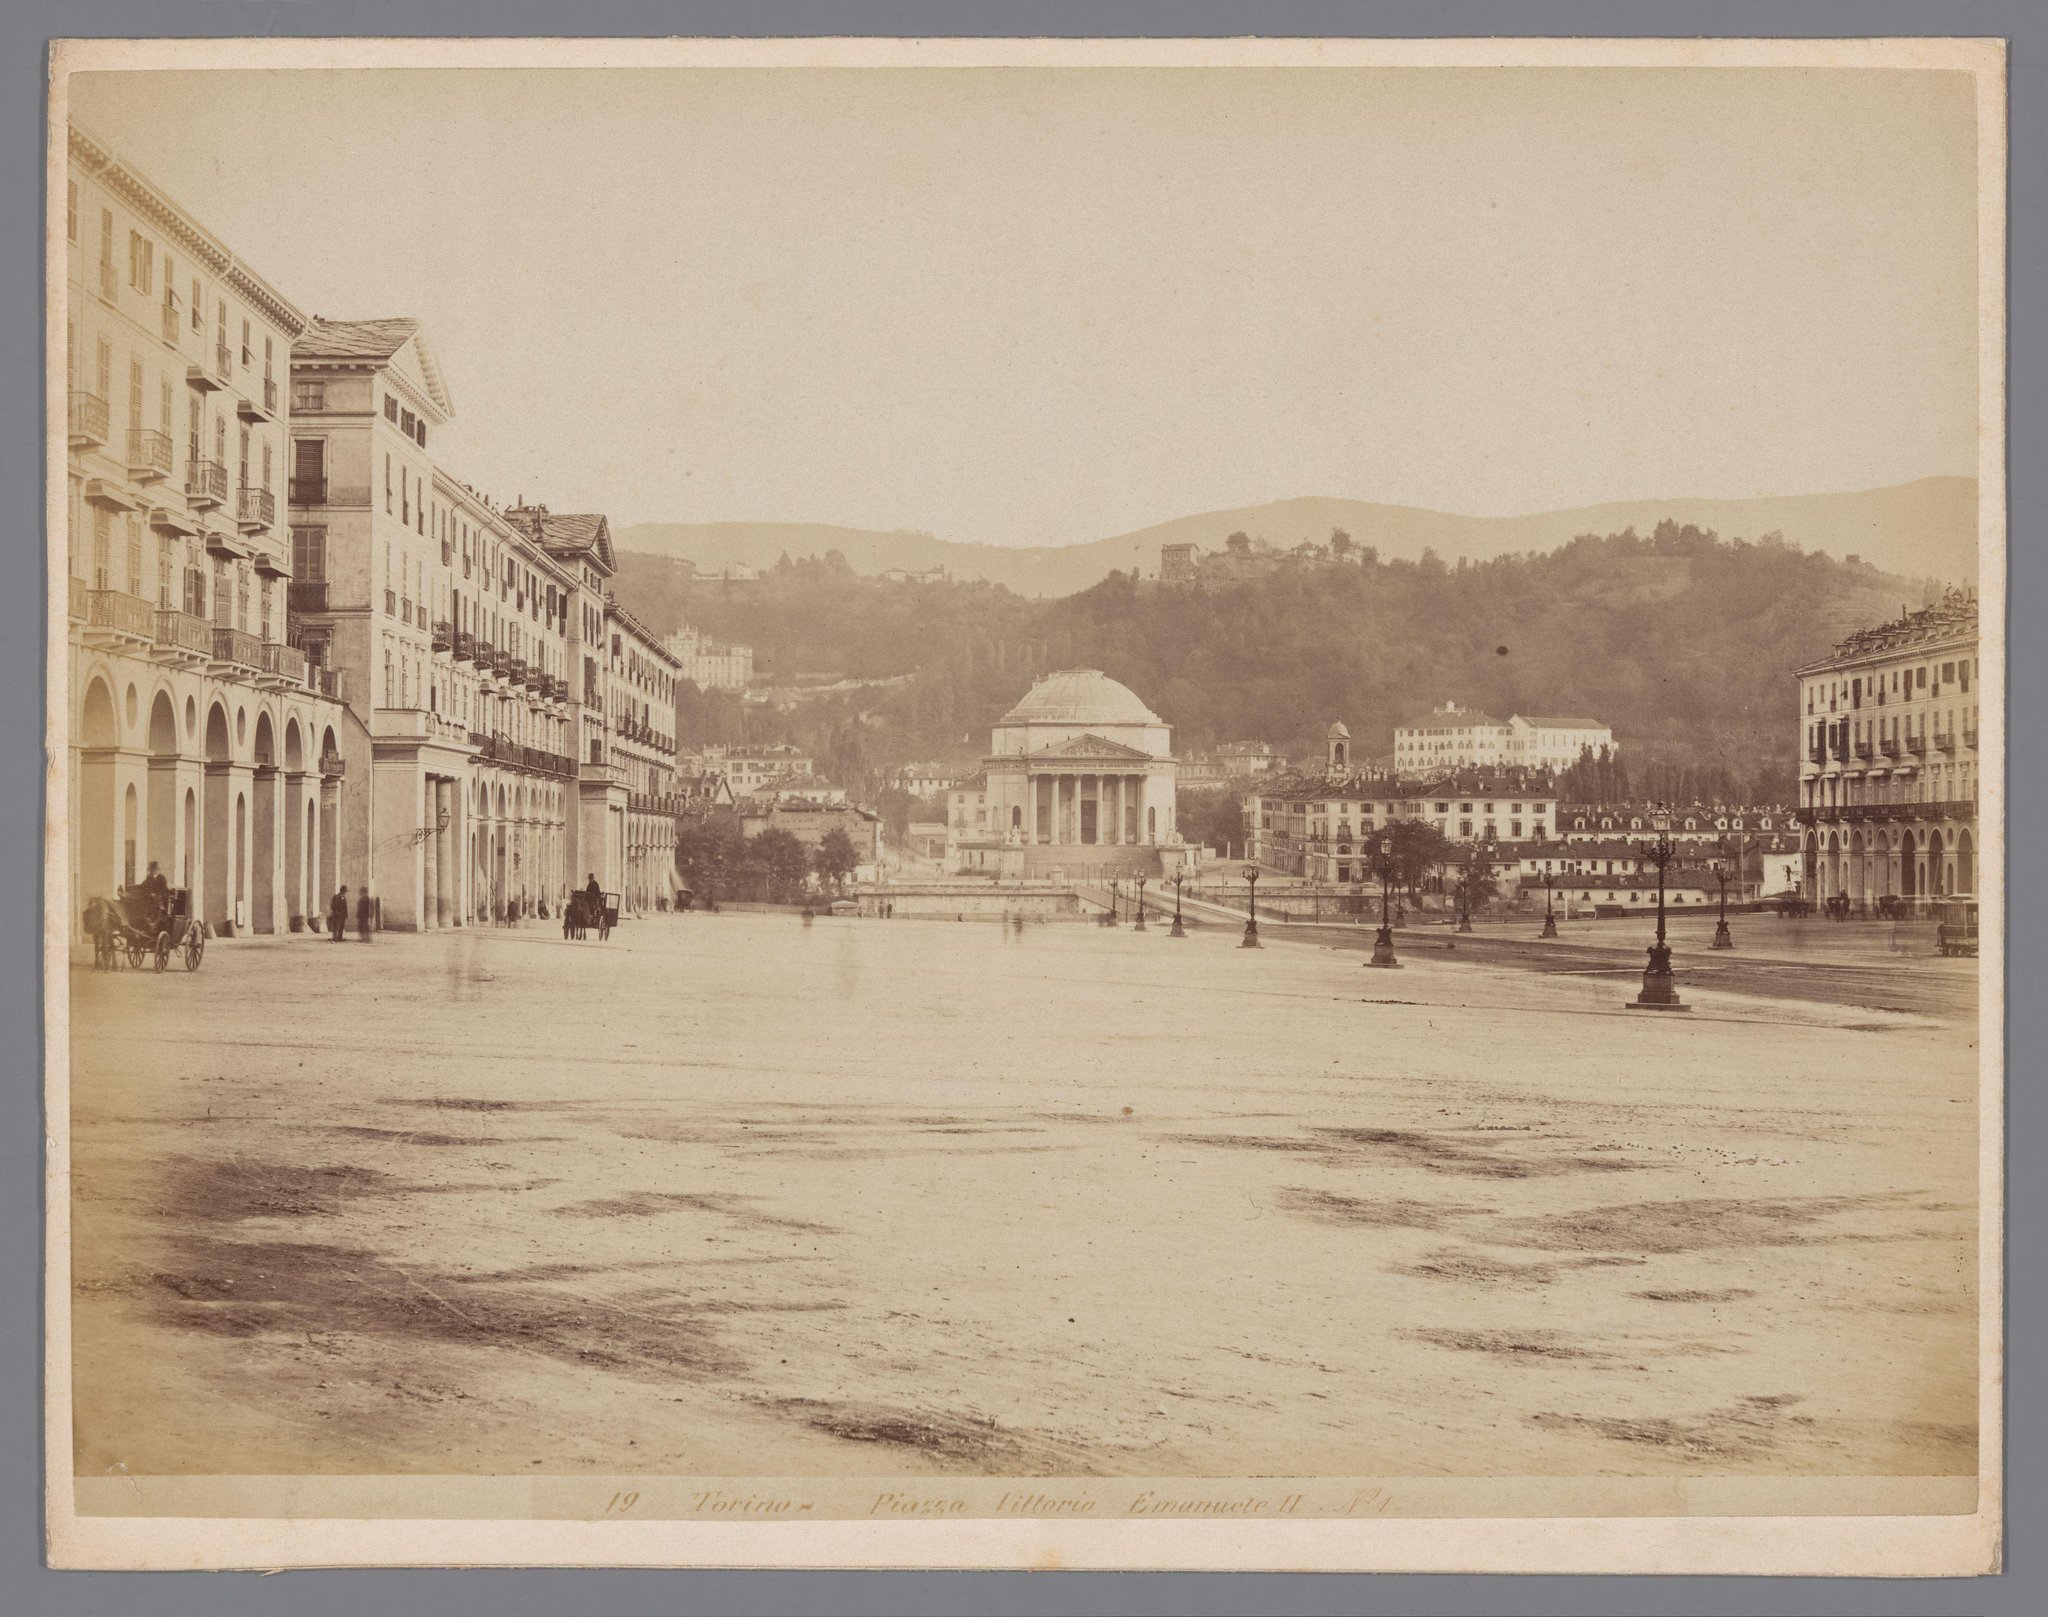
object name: photograph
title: Torino - Piazza Vittorio Emanuele II, no. 1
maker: Anonymous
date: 1851-1900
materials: cardboard, paper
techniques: albumen print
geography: turin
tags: square, place, circus, etc., urban housing, church (exterior)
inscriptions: number: ‘19’